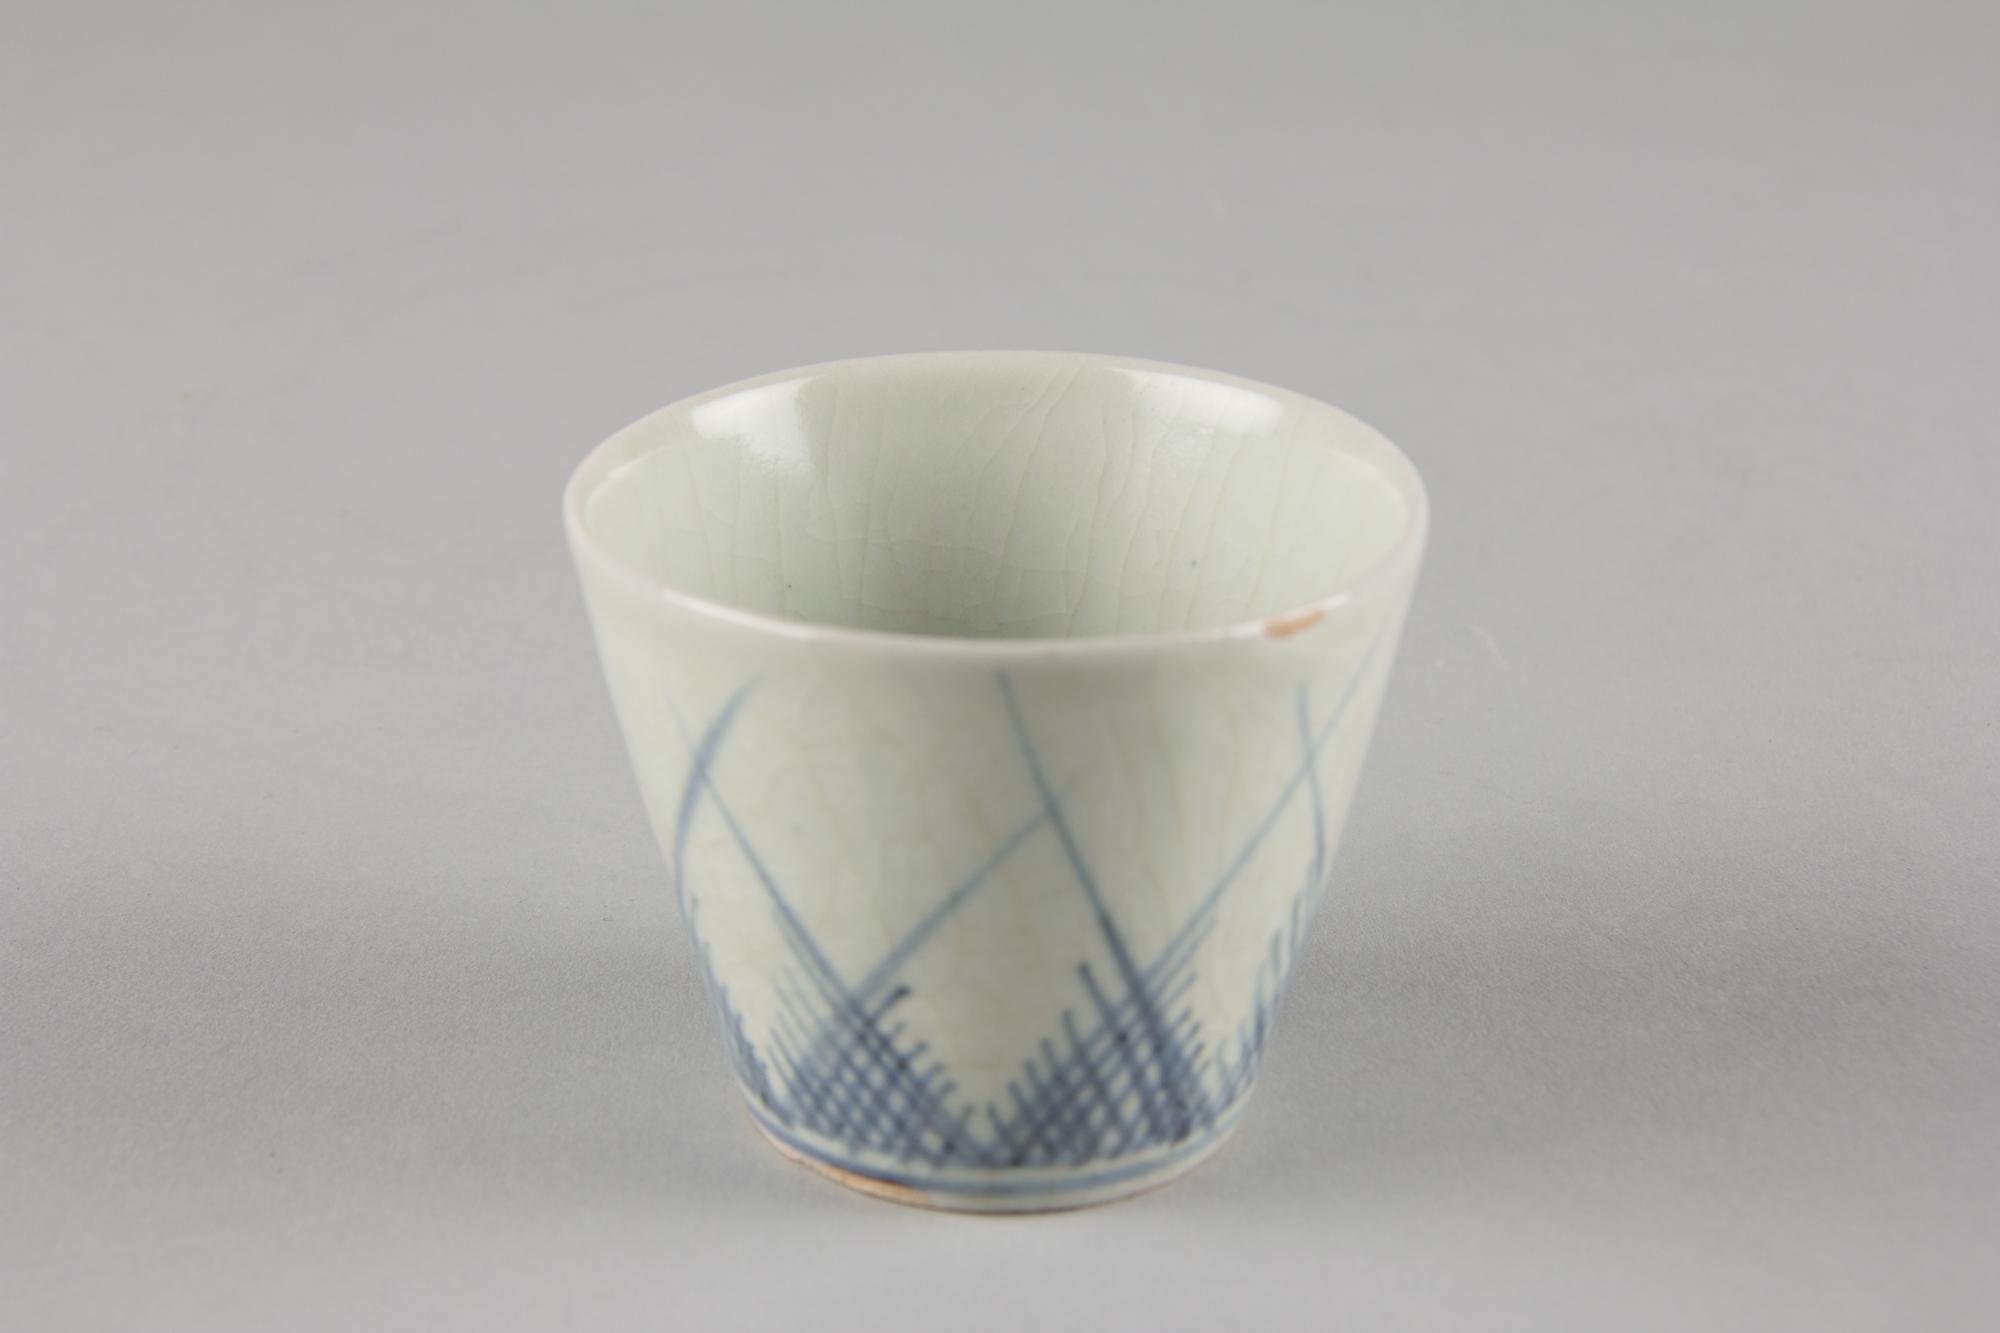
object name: soba cup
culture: japanese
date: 1734-1800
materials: porcelain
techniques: underglaze